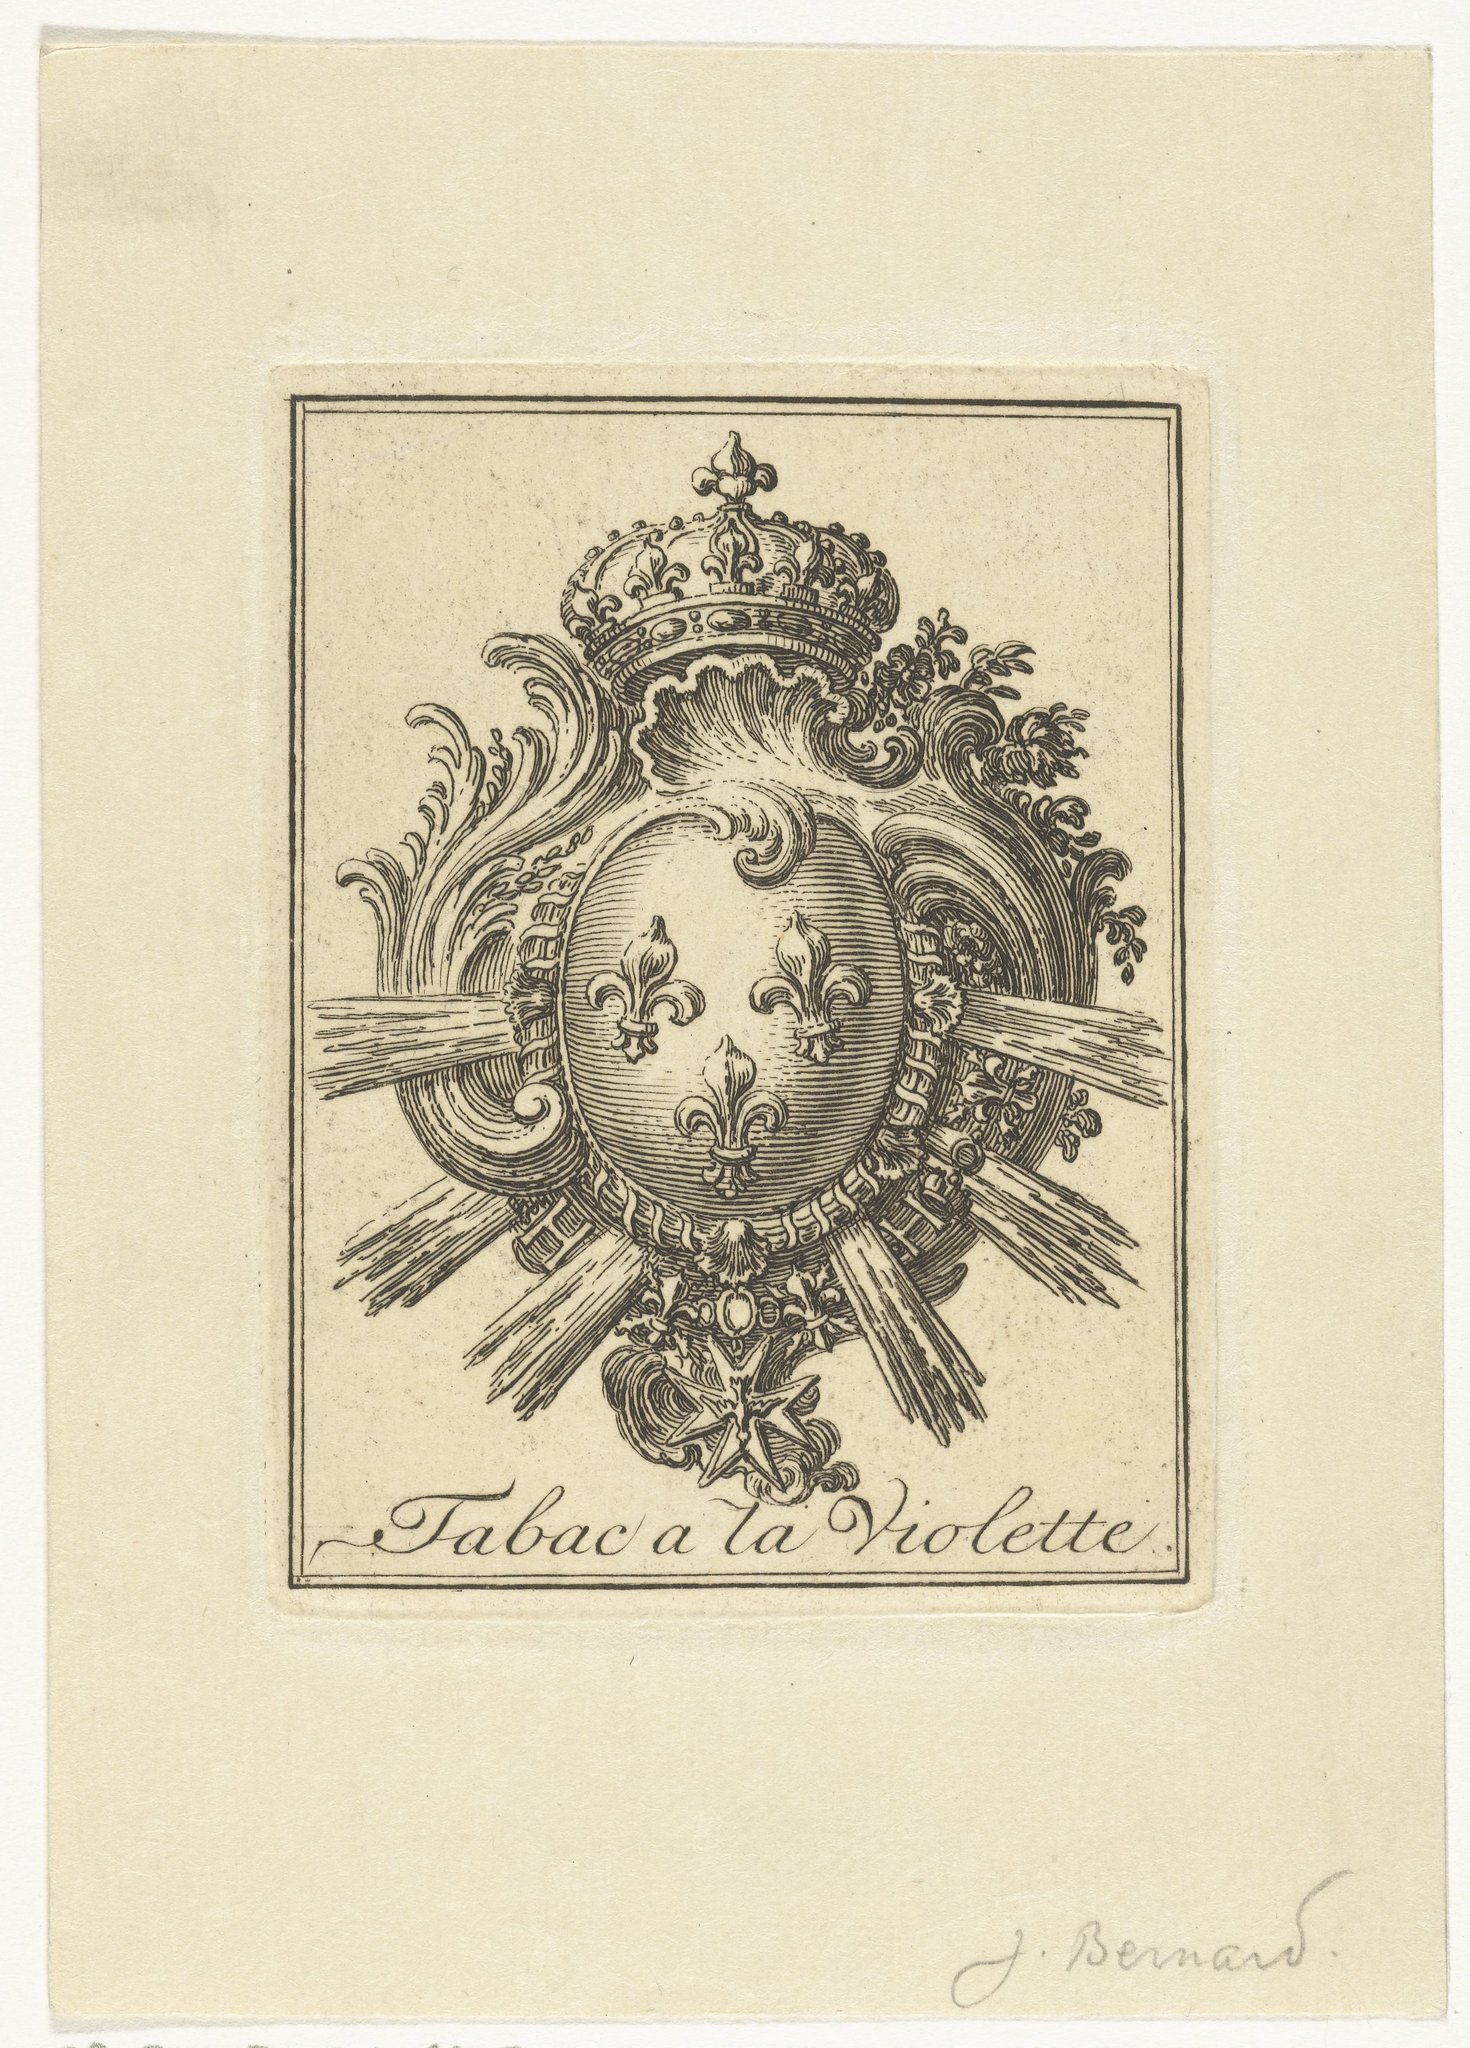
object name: print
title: Tabac a la Violette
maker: jean bernard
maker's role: draughtsman, print maker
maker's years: 1765-1833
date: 1785-1833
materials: paper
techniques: etching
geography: amsterdam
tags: trade mark, trade token, trade sign, trade card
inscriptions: collector's mark: Lugt 2228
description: Reclamekaart voor het tabaksmerk "Tabac a la Violette". Een wapen met drie lelies. Boven het wapen een kroon.